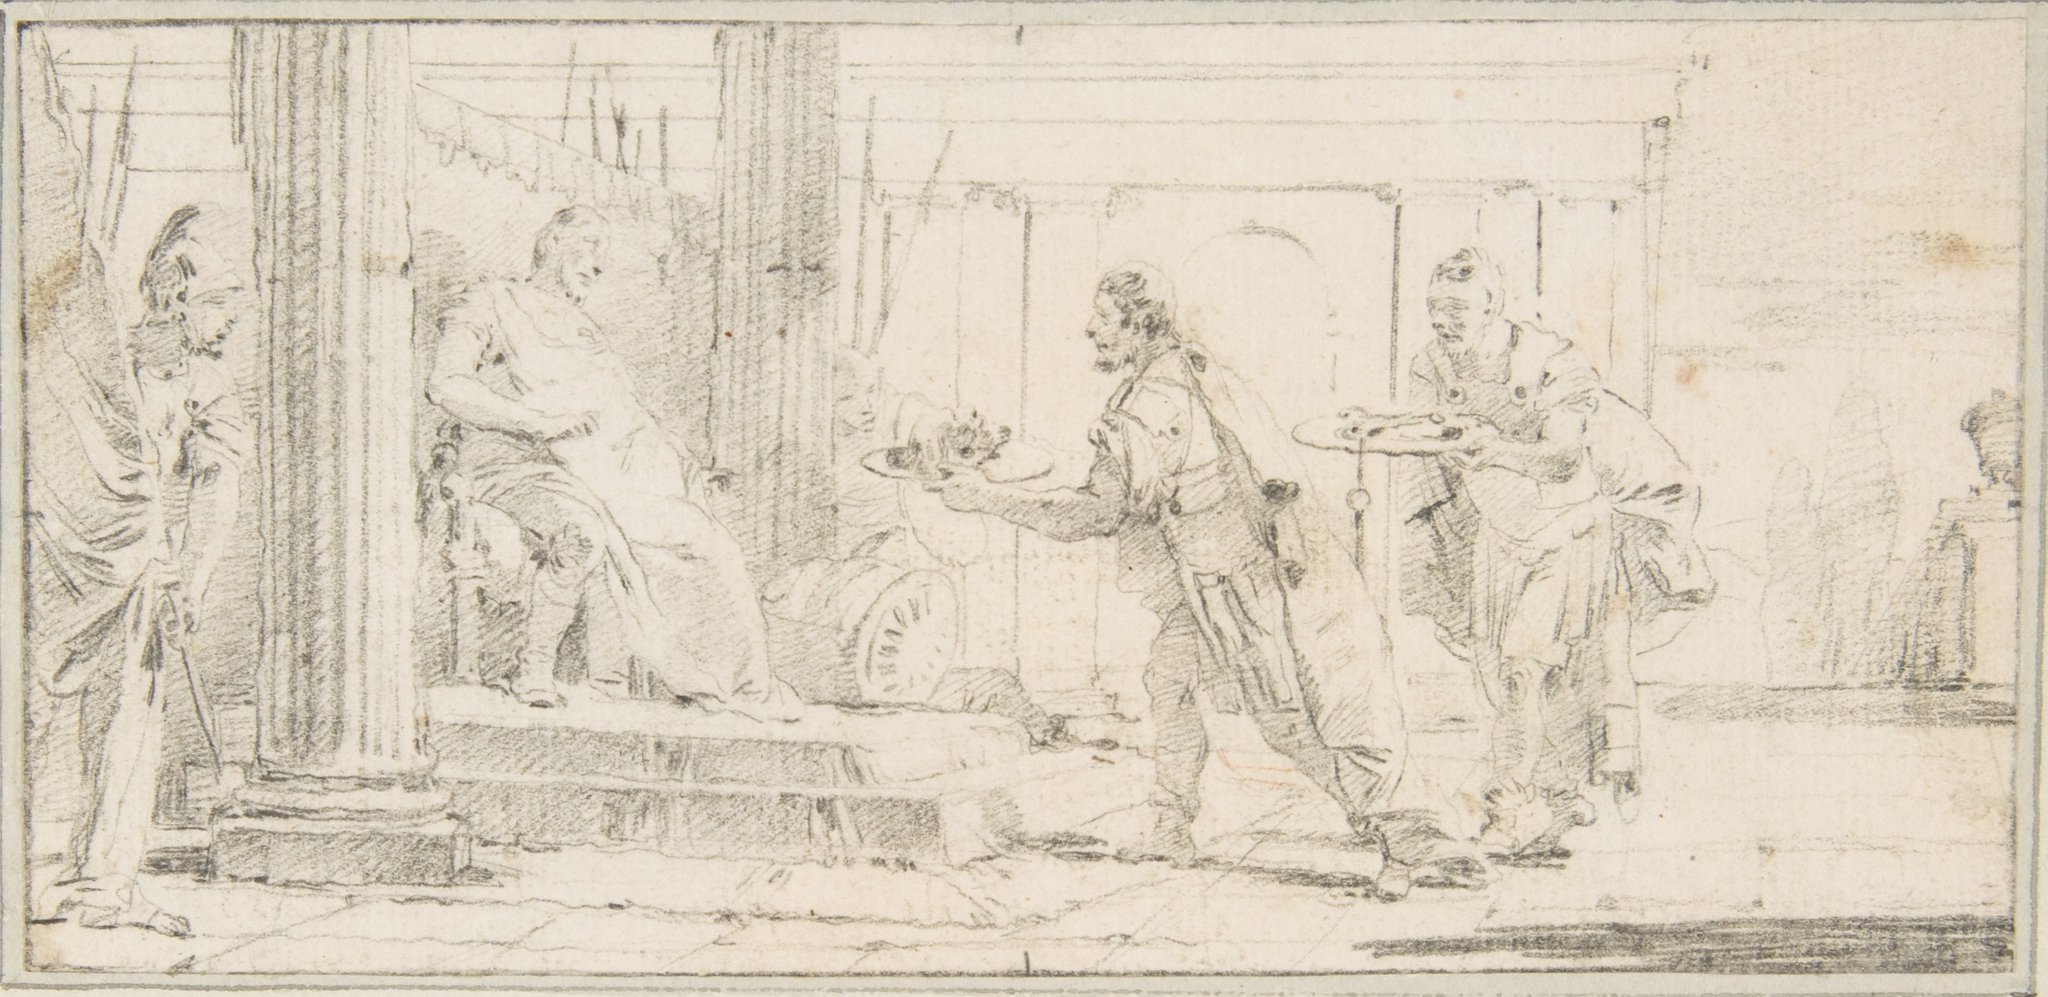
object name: drawing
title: Illustration for a Book: Soldiers Offering the Decapitated Head of a Man and Keys to a General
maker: giovanni battista tiepolo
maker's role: artist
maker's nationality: italian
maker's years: 1696-1770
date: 1696-1770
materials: chalk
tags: soldiers,heads,generals